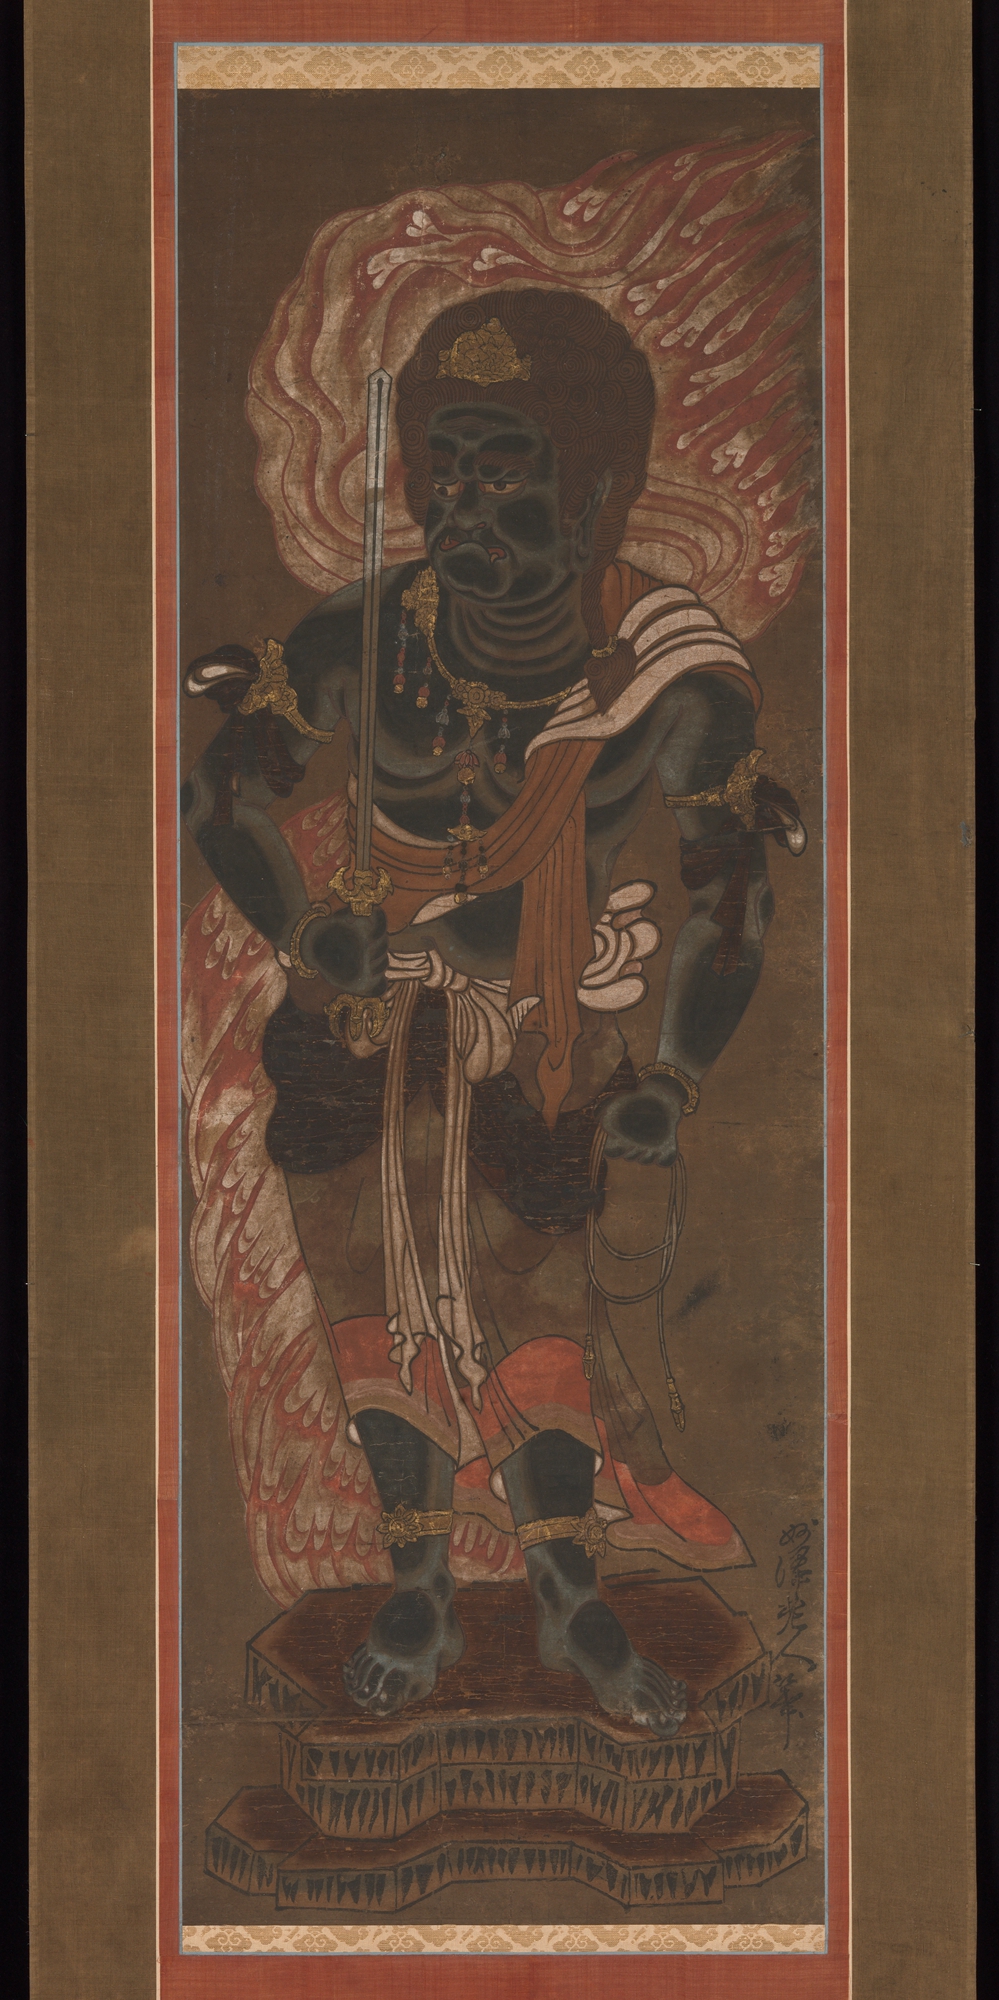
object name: hanging scroll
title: Fudō Myōō and Two Attendants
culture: japanese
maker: ryūshū shūtaku (myōtaku)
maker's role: artist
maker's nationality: japanese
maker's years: 1307-1388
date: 1301-1400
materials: paper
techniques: hand coloring, woodblock print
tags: swords,men,buddhism,deities